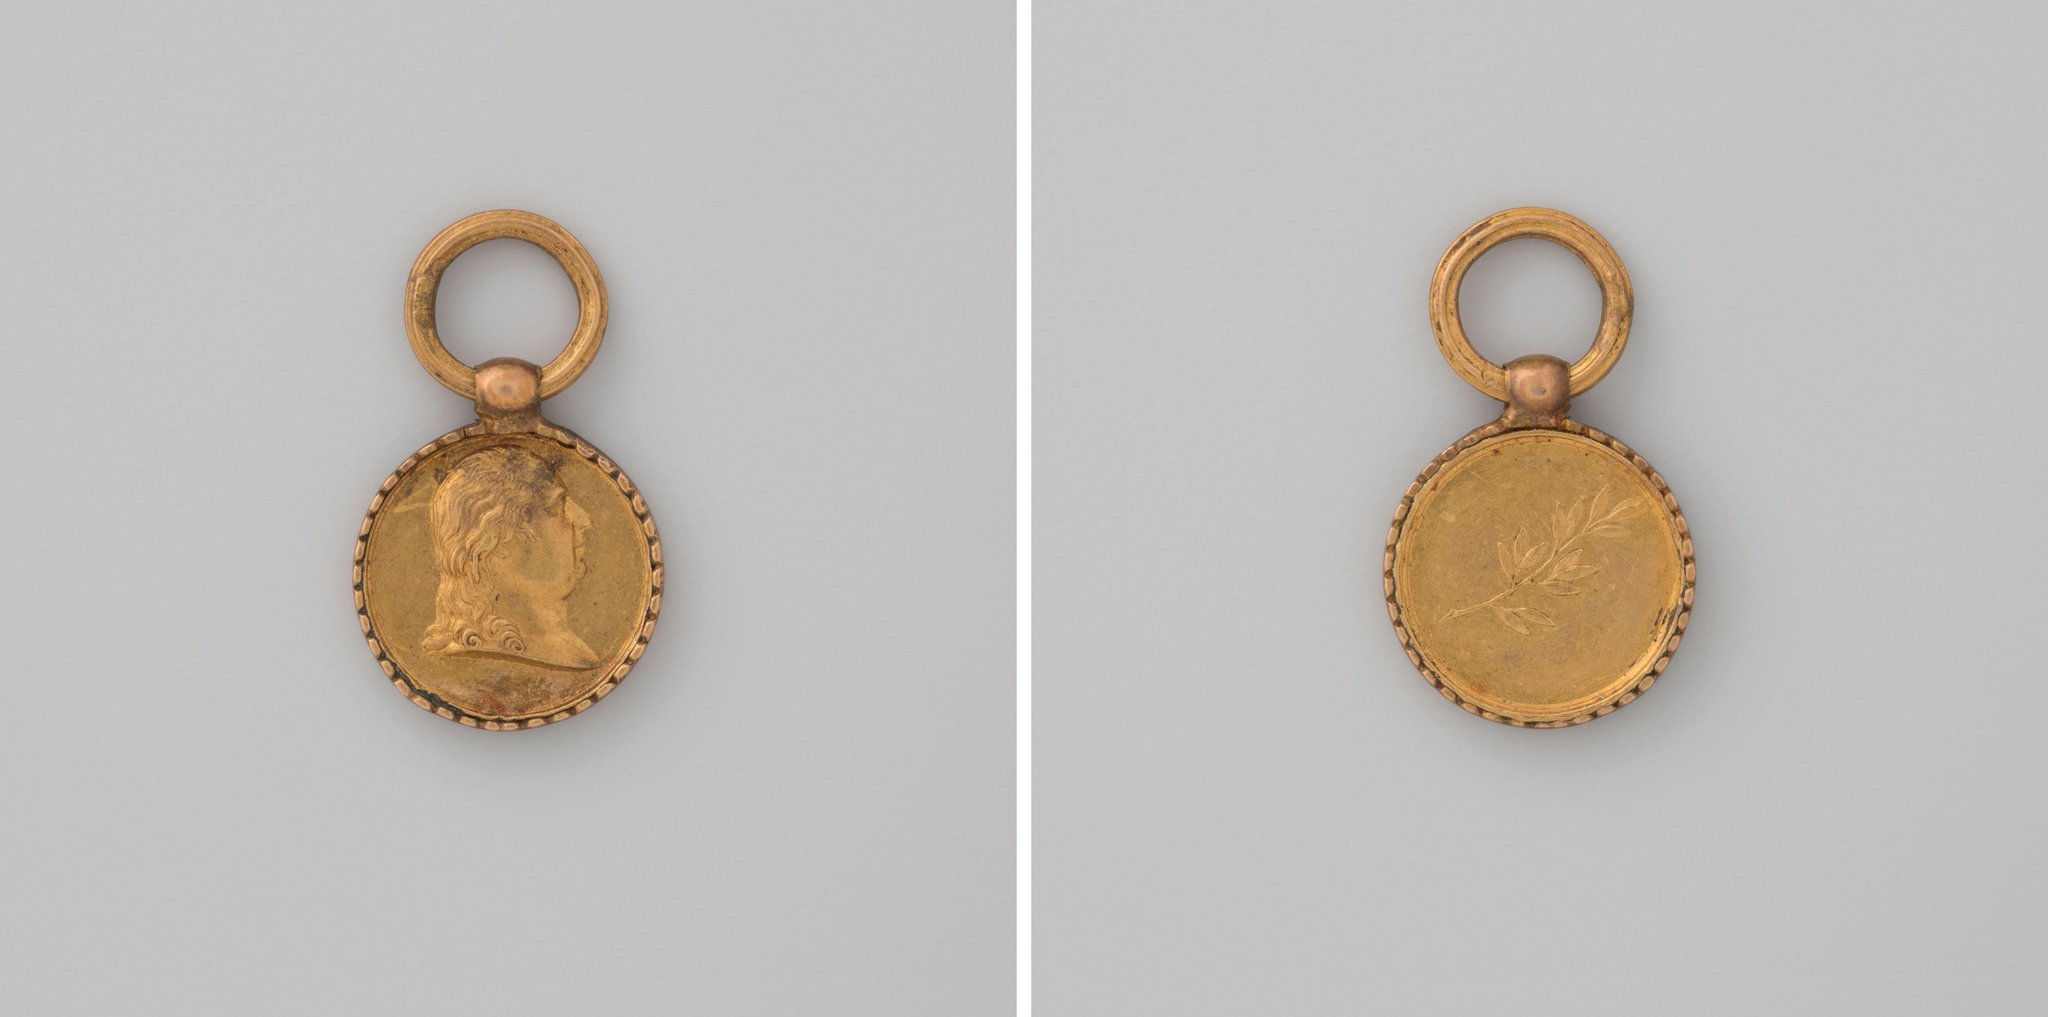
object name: history medal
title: Lodewijk XVIII, koning van Frankrijk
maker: Anonymous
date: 1815-1820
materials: gold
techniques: striking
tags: paris, lodewijk xviii (koning van frankrijk)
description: Gouden penning aan draagoog en draagring. Voorzijde: borststuk man binnen sierrand. Keerzijde: olijftak binnen sierrand.